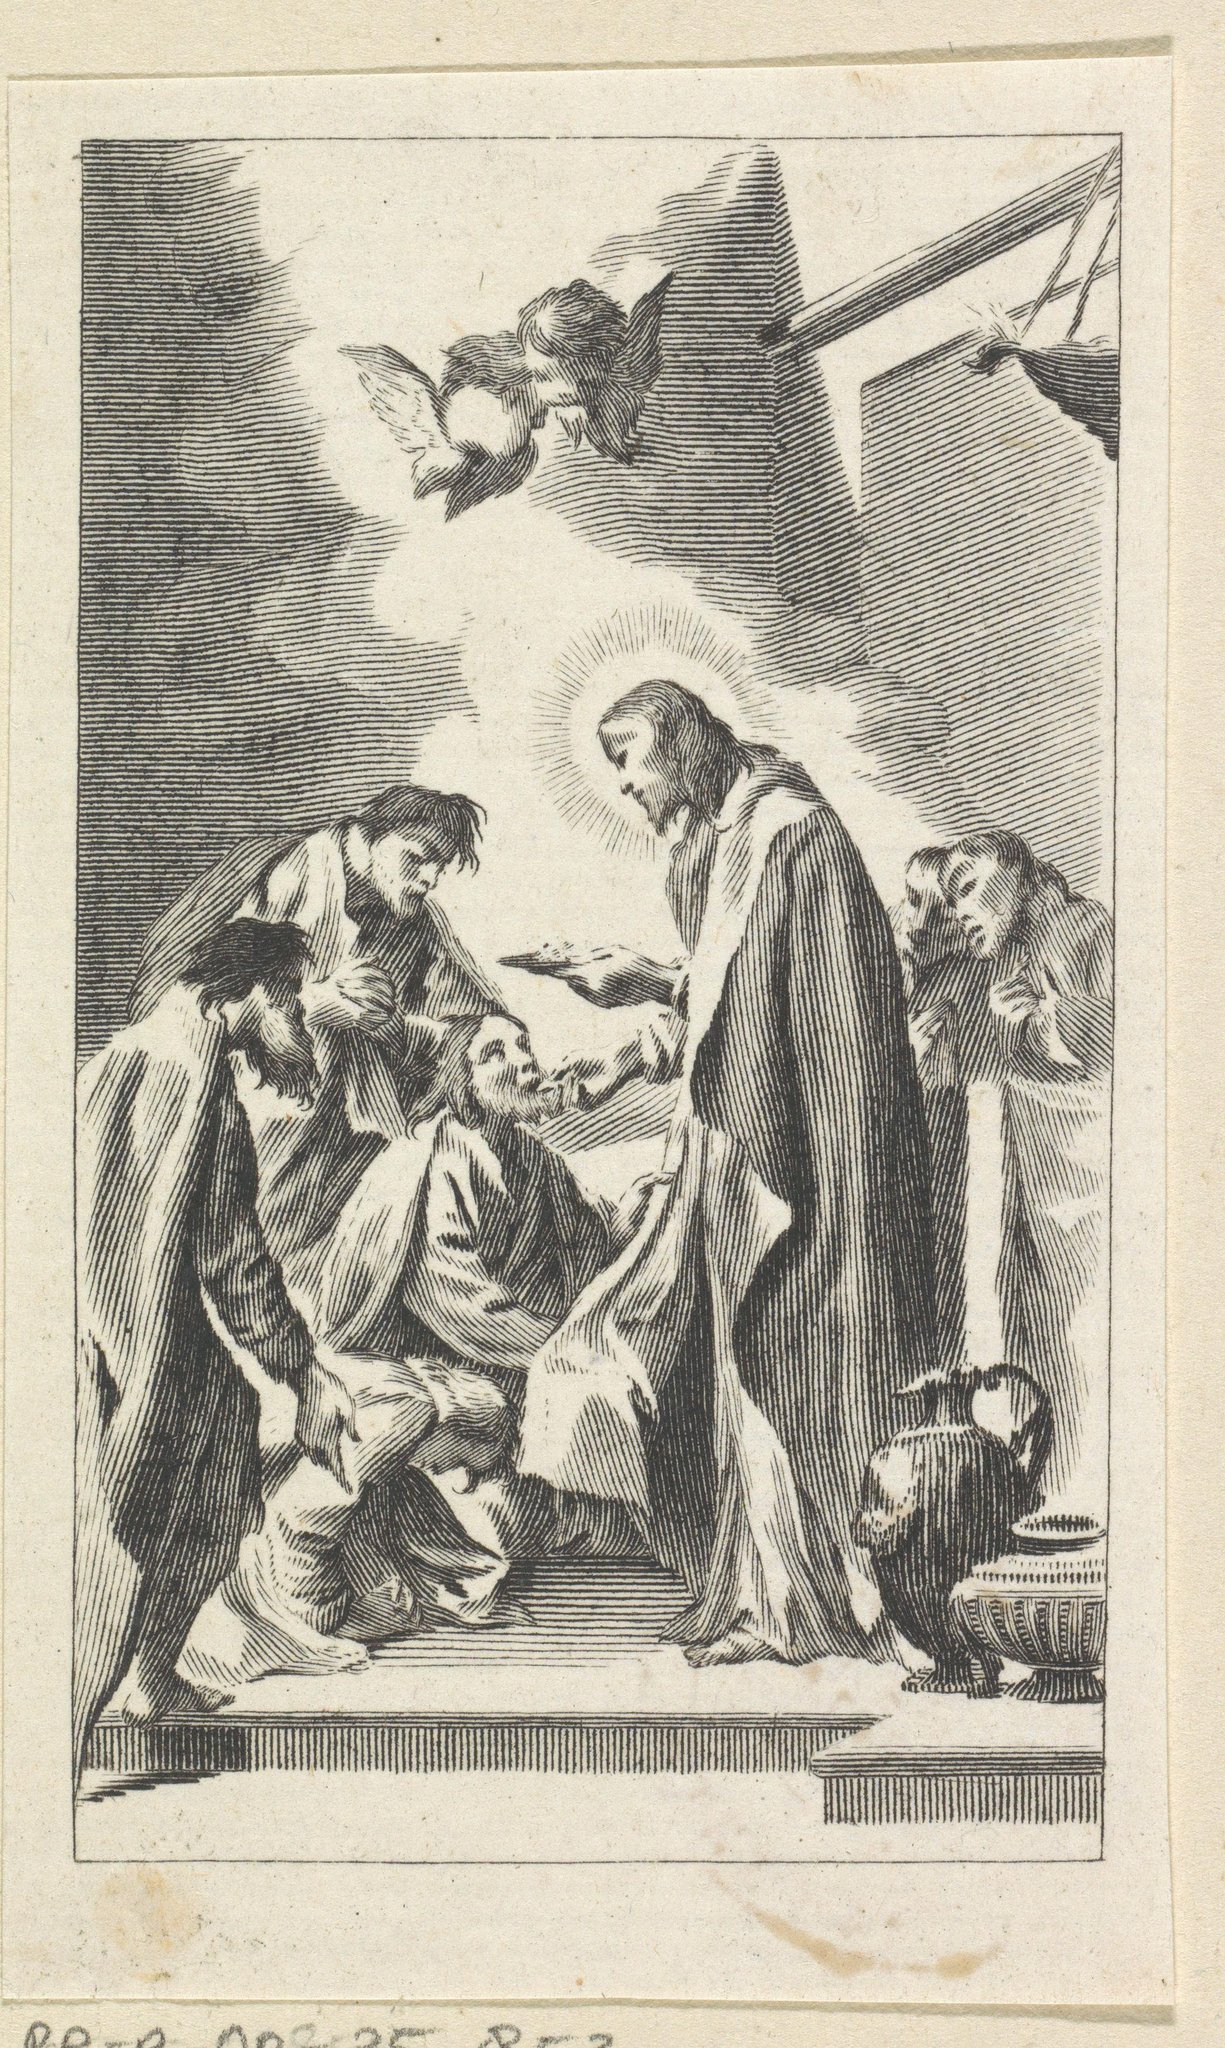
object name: print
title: Communie van de apostelen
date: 1740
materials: paper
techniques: engraving, etching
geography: venice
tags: communion of the apostles: christ giving bread (host) and/or wine to the (standing) apostles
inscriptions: collector's mark: Lugt 240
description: Prent uit een reeks van 16 prenten plus een titelprent.